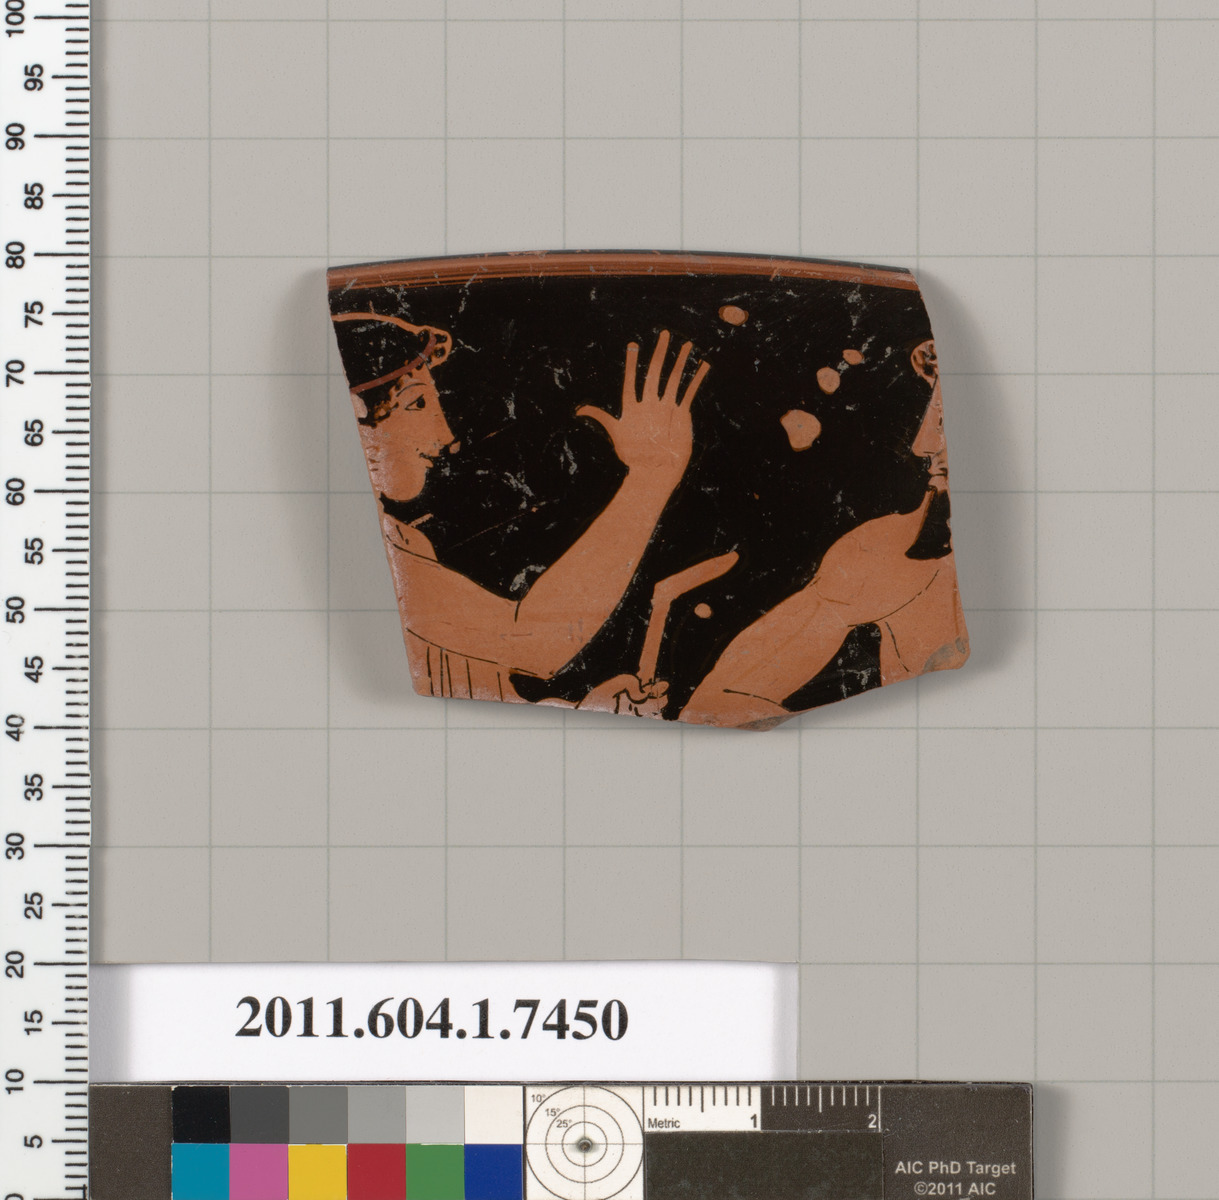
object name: kylix fragment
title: Terracotta rim fragment of a kylix (drinking cup)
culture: greek, attic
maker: hermonax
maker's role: artist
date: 470-460 BCE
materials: terracotta